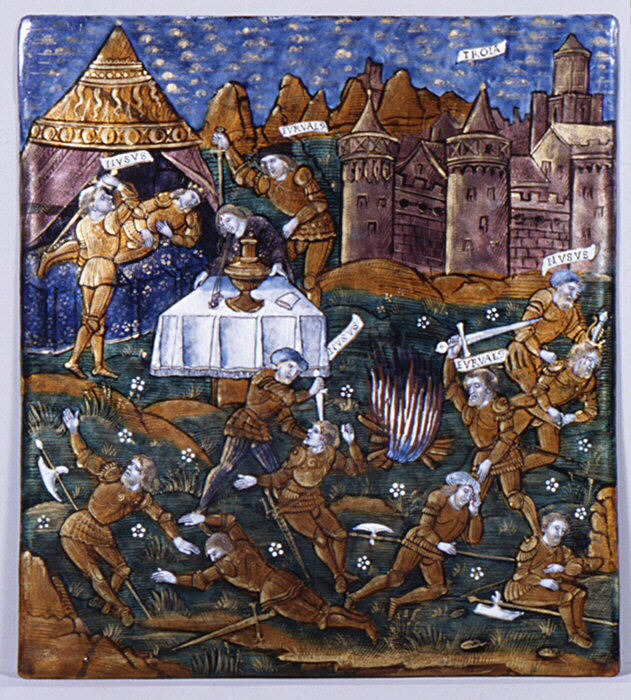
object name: plaque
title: Nisus and Euryalus Surprise the Rutuli in their Camp (Aeneid, Book IX)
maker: master of the aeneid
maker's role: artist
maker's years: 1525-1545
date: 1530-1535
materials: copper, enamel, gilt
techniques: painting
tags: battles,aeneas